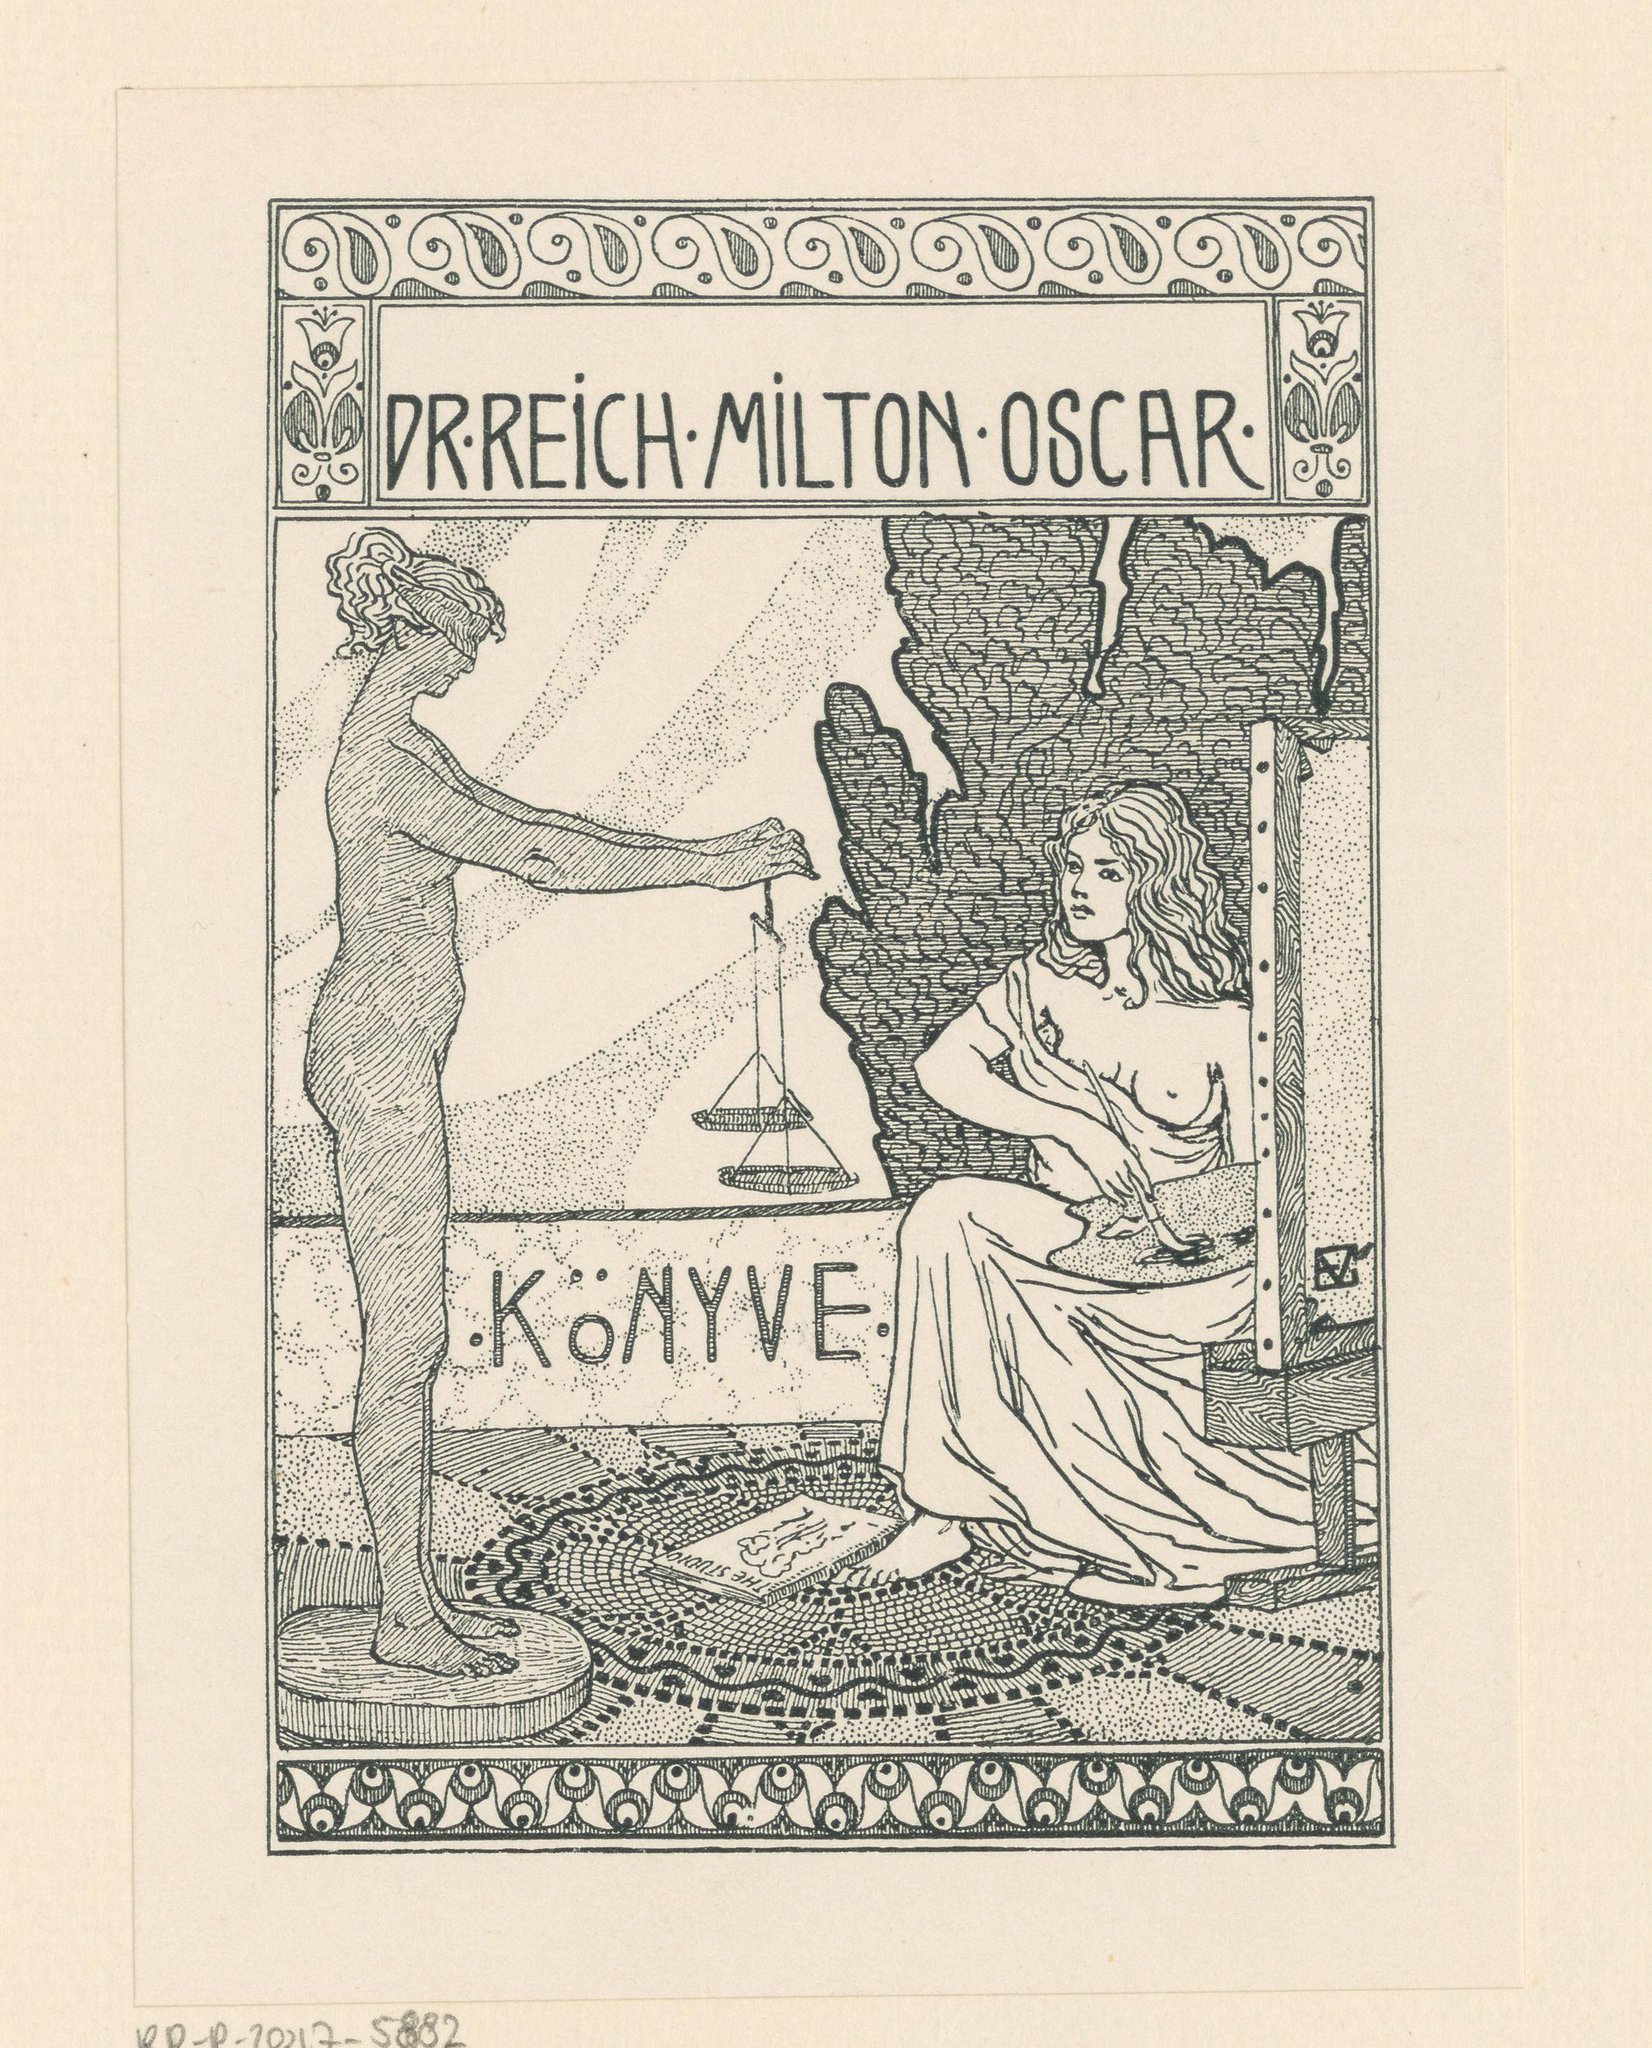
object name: bookplate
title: Ex libris van Milton Oscar Reich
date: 1878-1913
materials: paper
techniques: printing block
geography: hungary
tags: 'pictura', symbolic representations, allegories and emblems ~ painting; 'pittura' (ripa), justitia (justice) as roman personification, painter working from nude model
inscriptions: inscription: ‘Dr. Reich / Budapest’, collector's mark: Lugt 2760, collector's mark: Lugt 2233